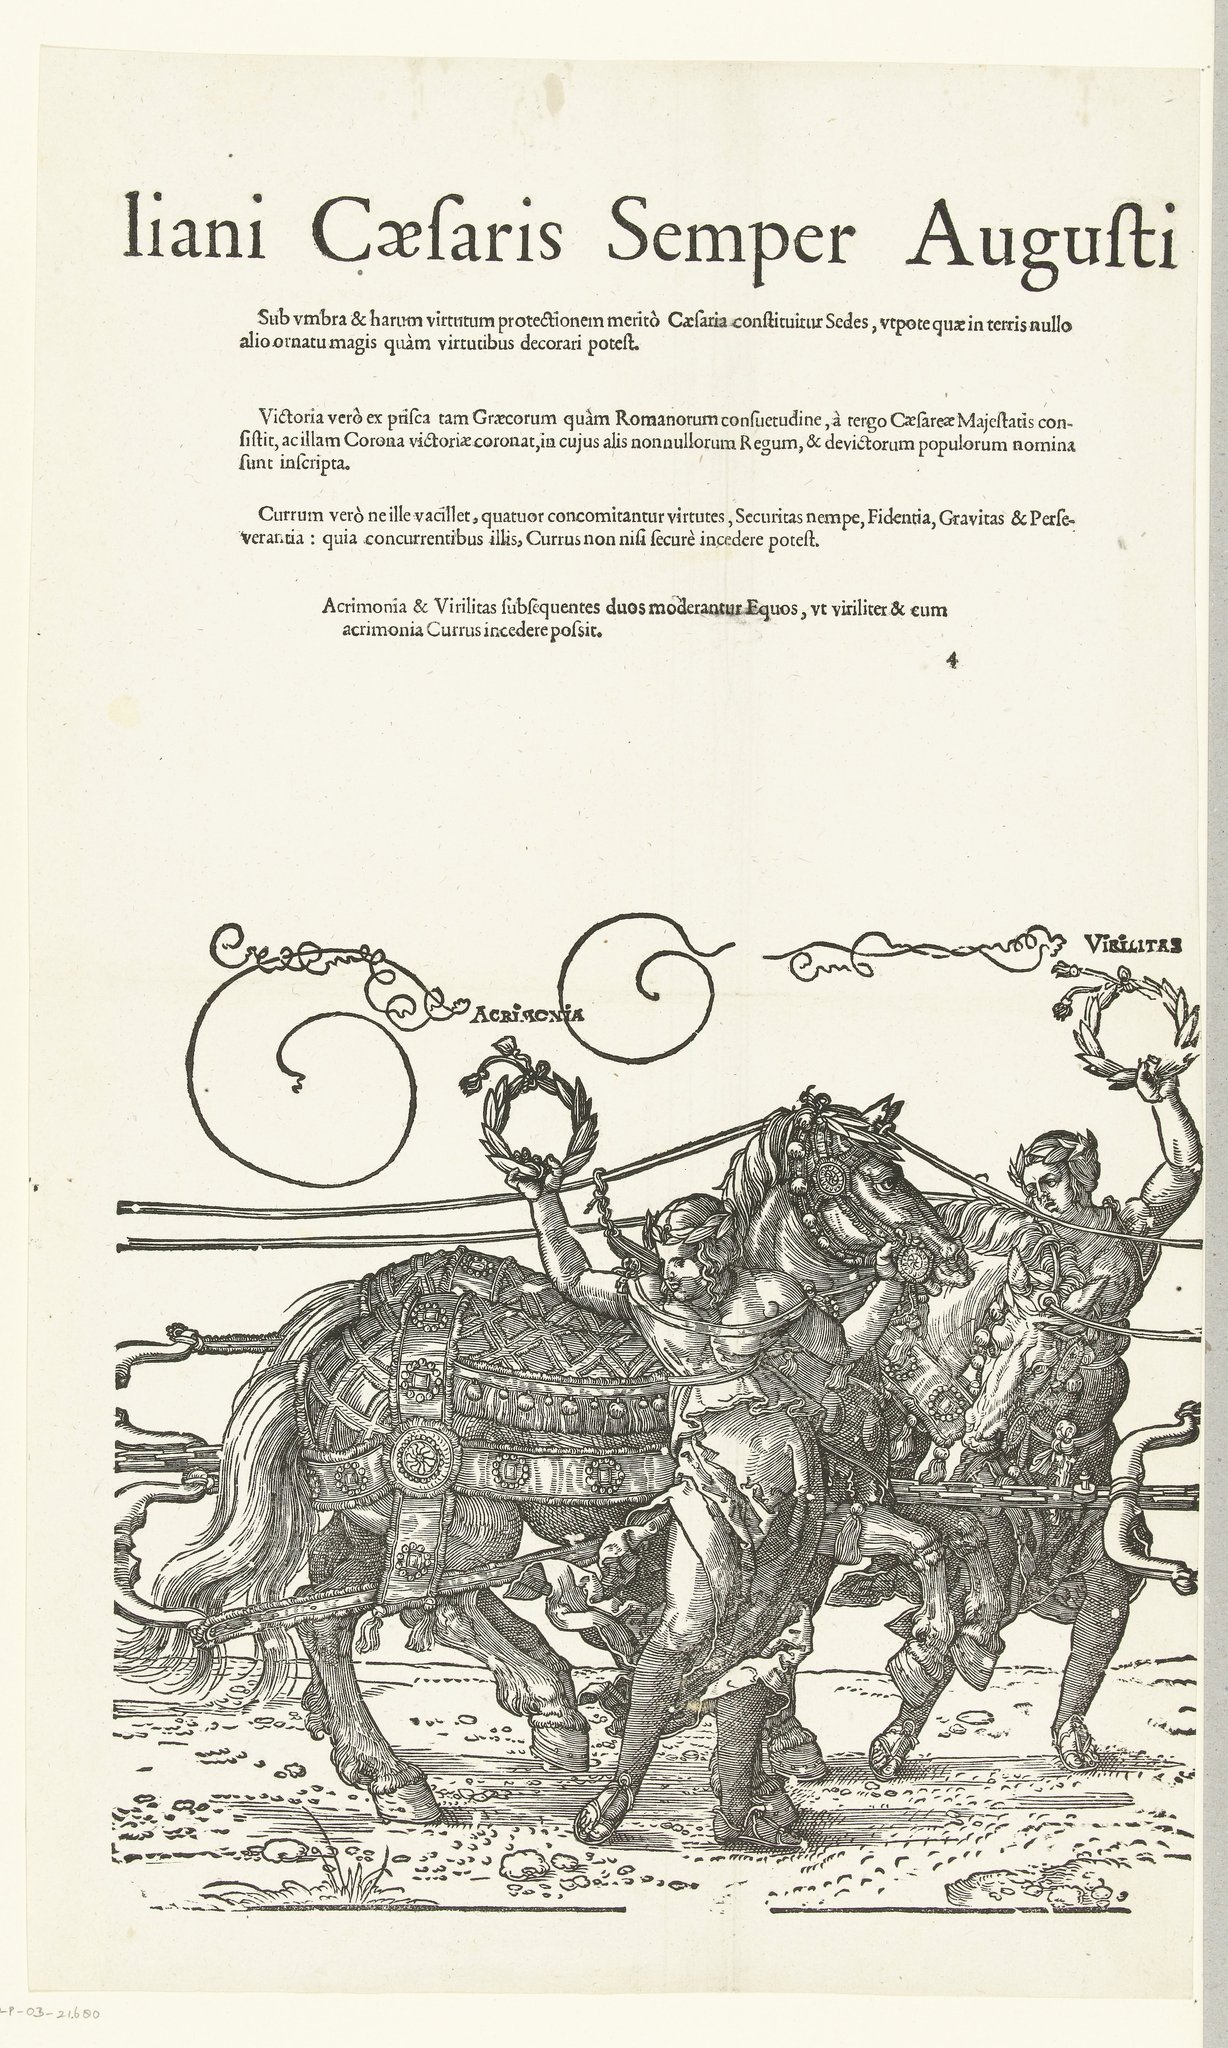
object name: print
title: Triomfwagen van keizer Maximiliaan I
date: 1527-1529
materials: paper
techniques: letterpress printing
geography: amsterdam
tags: maximilian i (holy roman emperor), chariot, triumphal car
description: De grote triomfwagen ter ere van keizer Maximiliaan I bij zijn overlijden op 12 januari 1519. Zesde blad met het vierde span paarden met Acrimonia en Virilitas.